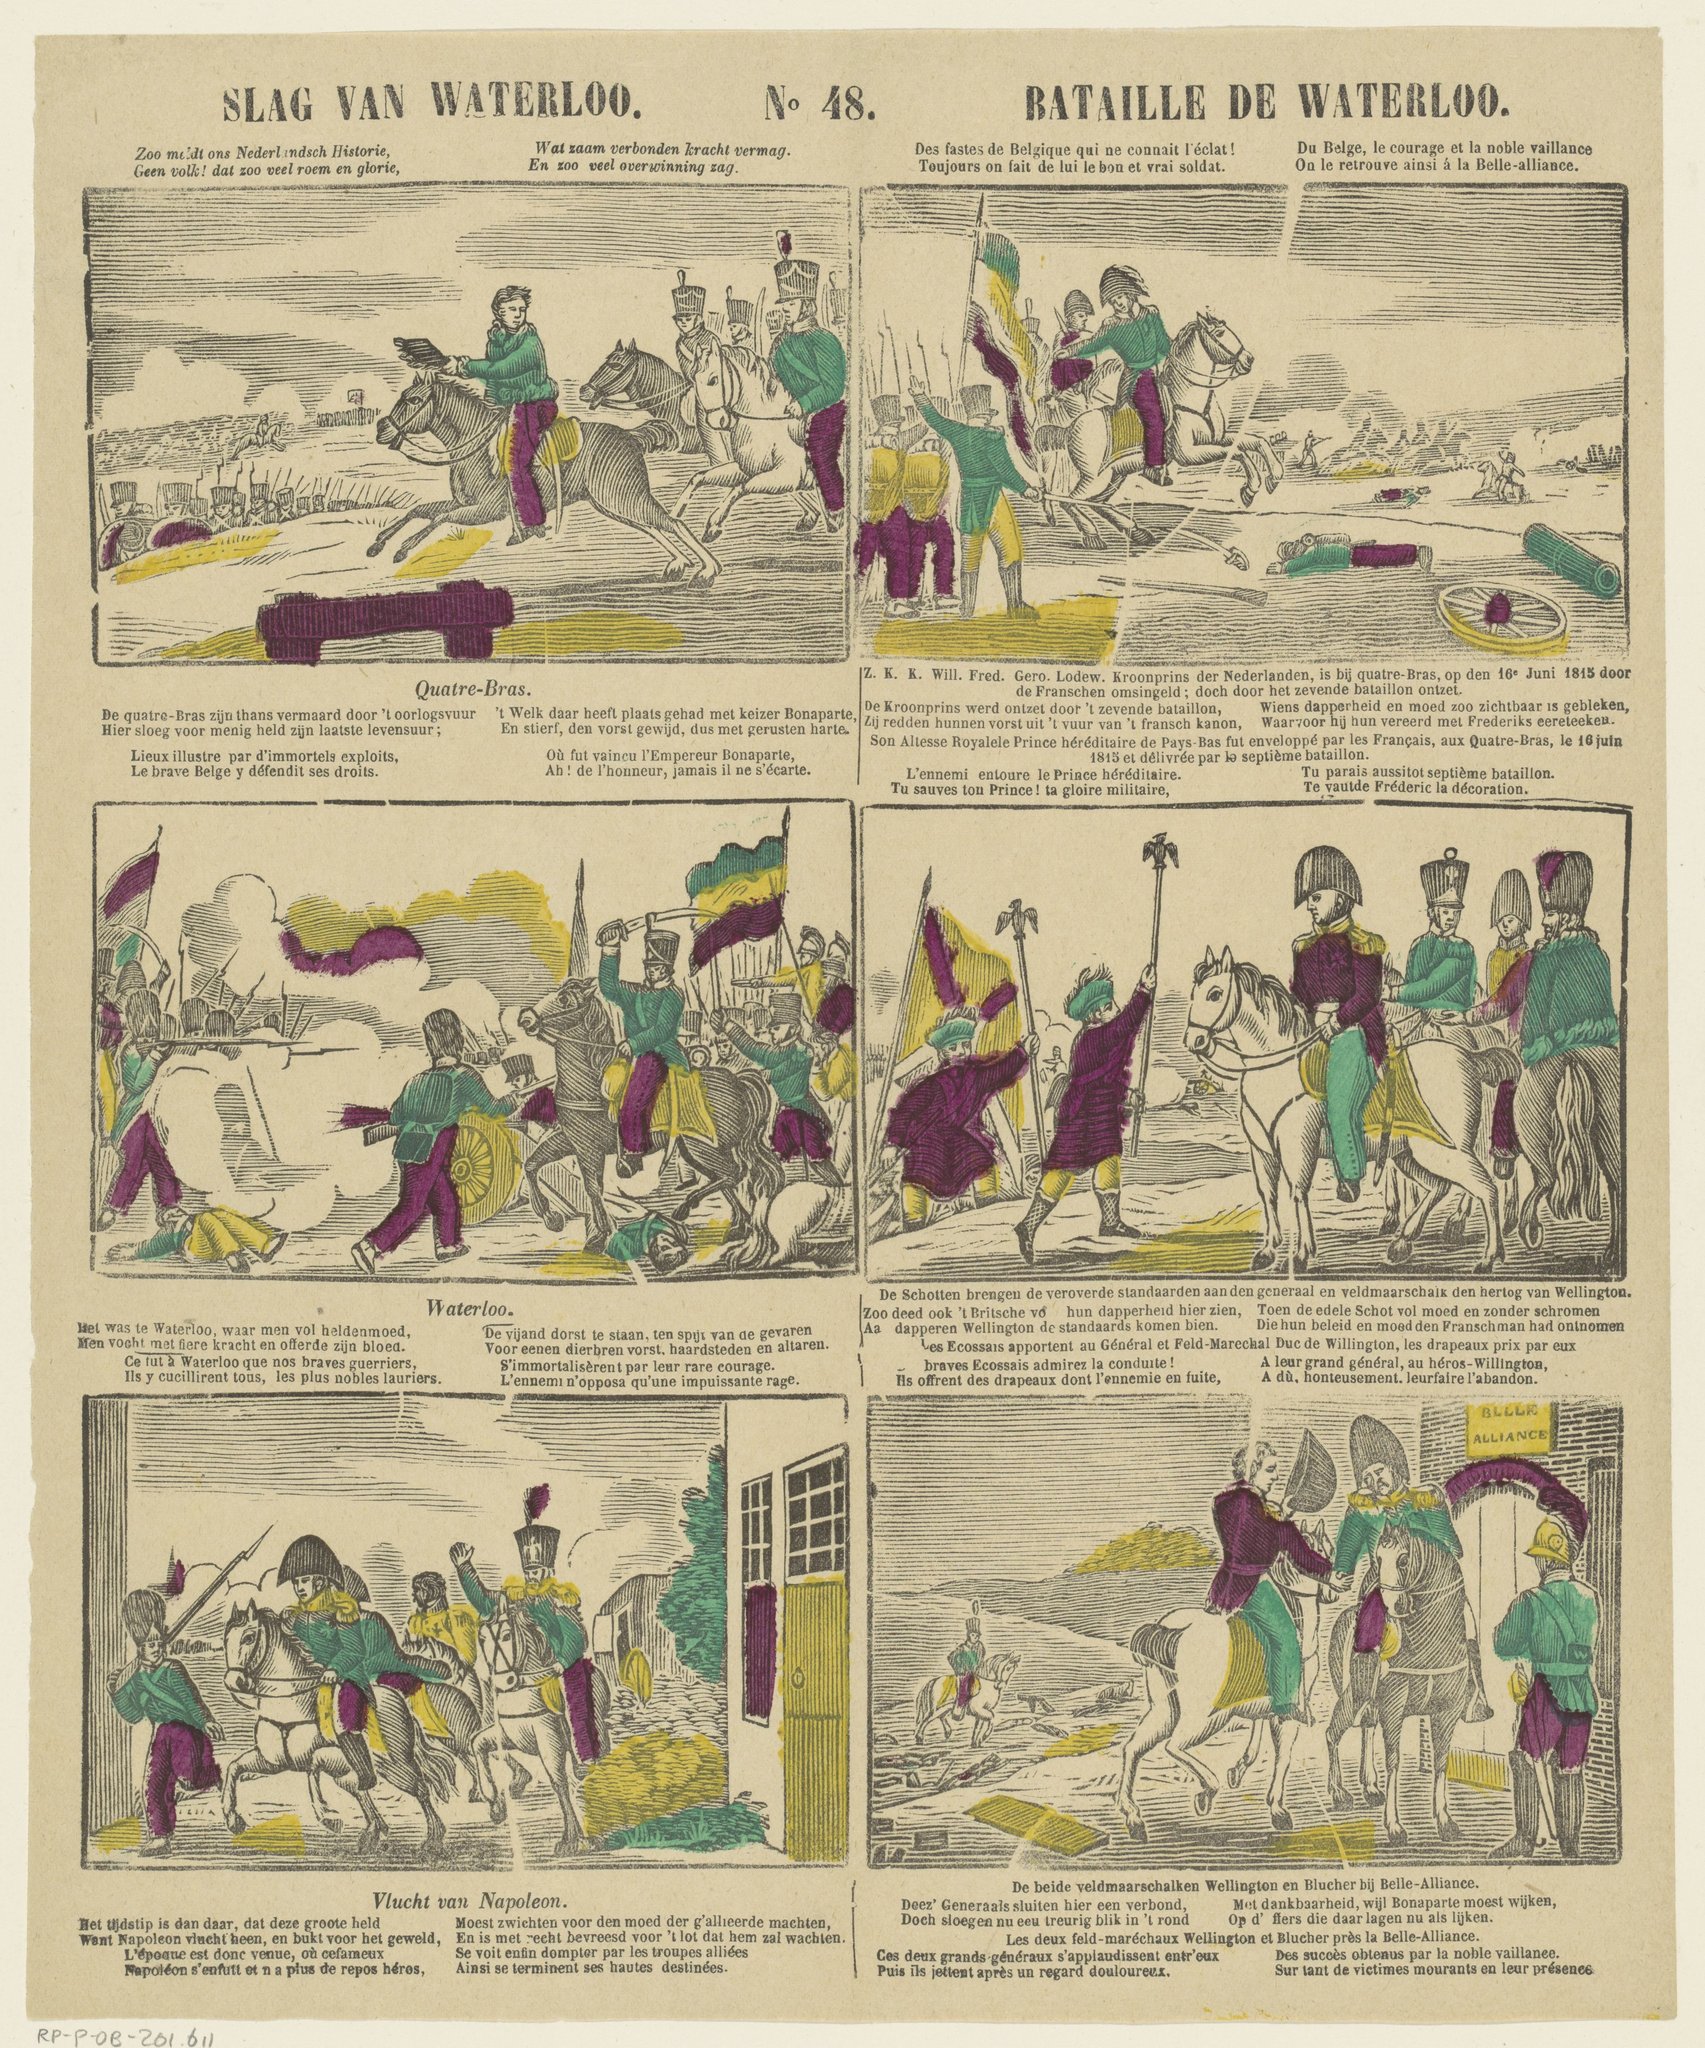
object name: popular print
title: Slag van Waterloo / Bataille de Waterloo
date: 1800-1833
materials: paper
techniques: colour, letterpress printing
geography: turnhout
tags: battle, the soldier; the soldier's life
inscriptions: collector's mark: Lugt 2760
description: Blad met 6 voorstellingen over de Slag bij Waterloo. Onder elke voorstelling een vierregelig vers in het Nederlands en in het Frans. Genummerd midden boven: 48.